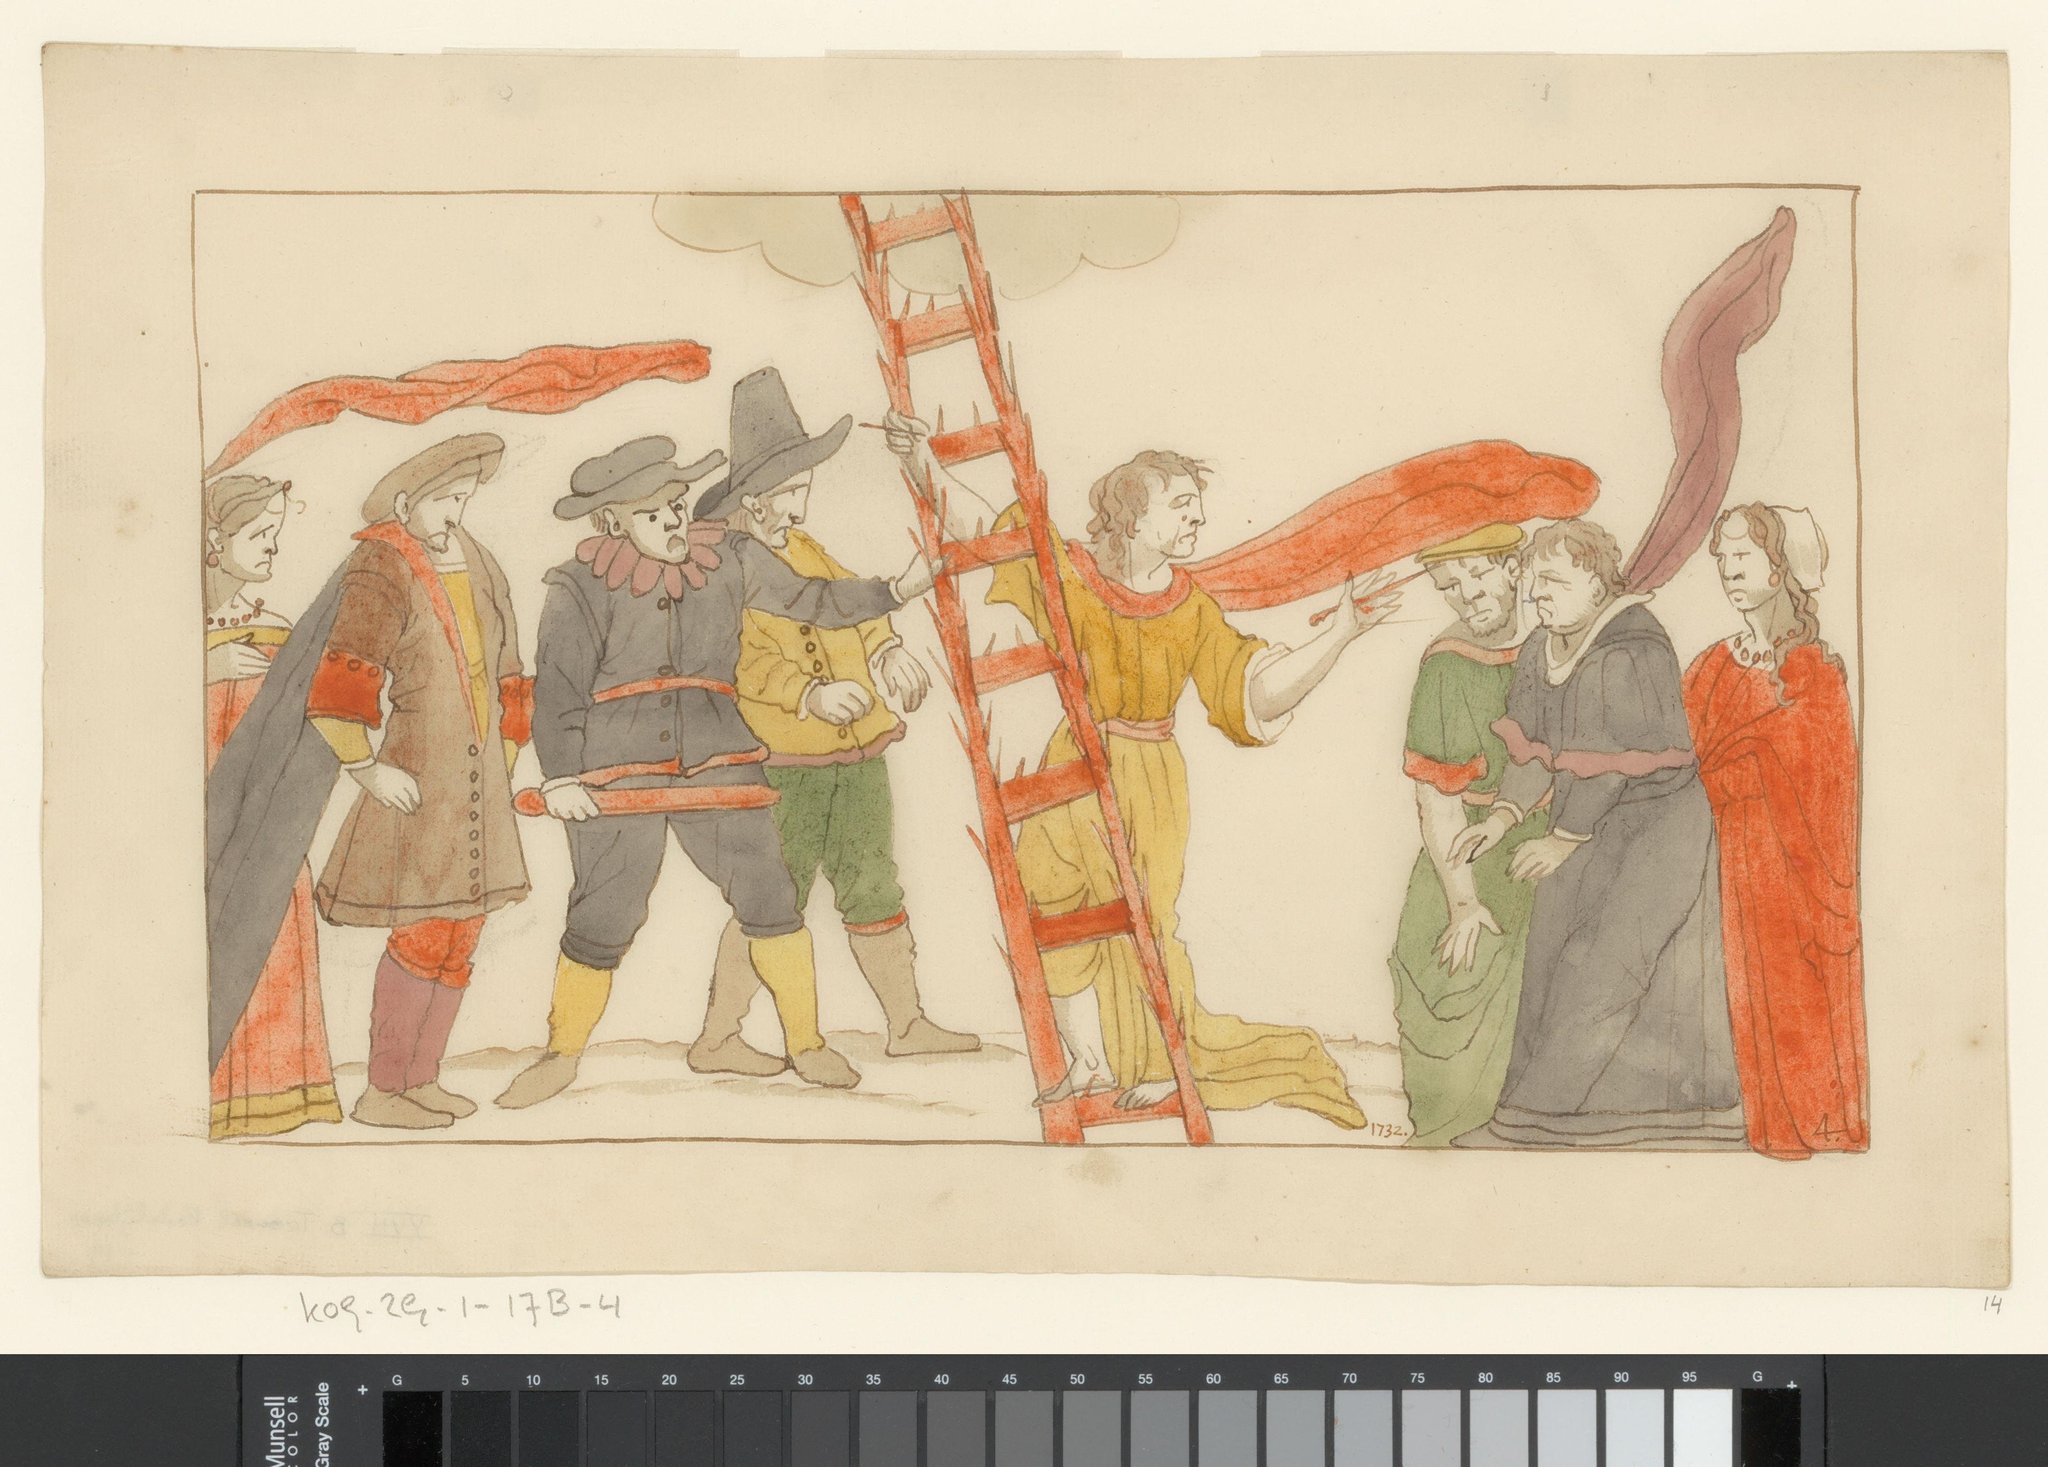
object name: drawing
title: Leer-comoedie in Brabant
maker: Anonymous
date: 1800-1847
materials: ink, paper, watercolor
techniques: brush, pen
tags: pageant of a guild, 'rhetorica', 'eloquentia' (~ trivium); 'rettorica' (ripa), chamber of rhetoric (dutch: 'rederijkerskamer'), ladder, stairway to heaven, haarlem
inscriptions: collector's mark: Lugt 1641, stamp:, stamp: Lugt 1641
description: Oude vrouw op een splinterige ladder naar de hemel. Zij toont een splinter die haar hand doorboort. Om haar heen verschillende boze mannen en vrouwen. Onderwerpsrubrieken binnen de Atlas Zeden en Gewoonten: Schoone kunsten, Tooneel, Rederijkers.